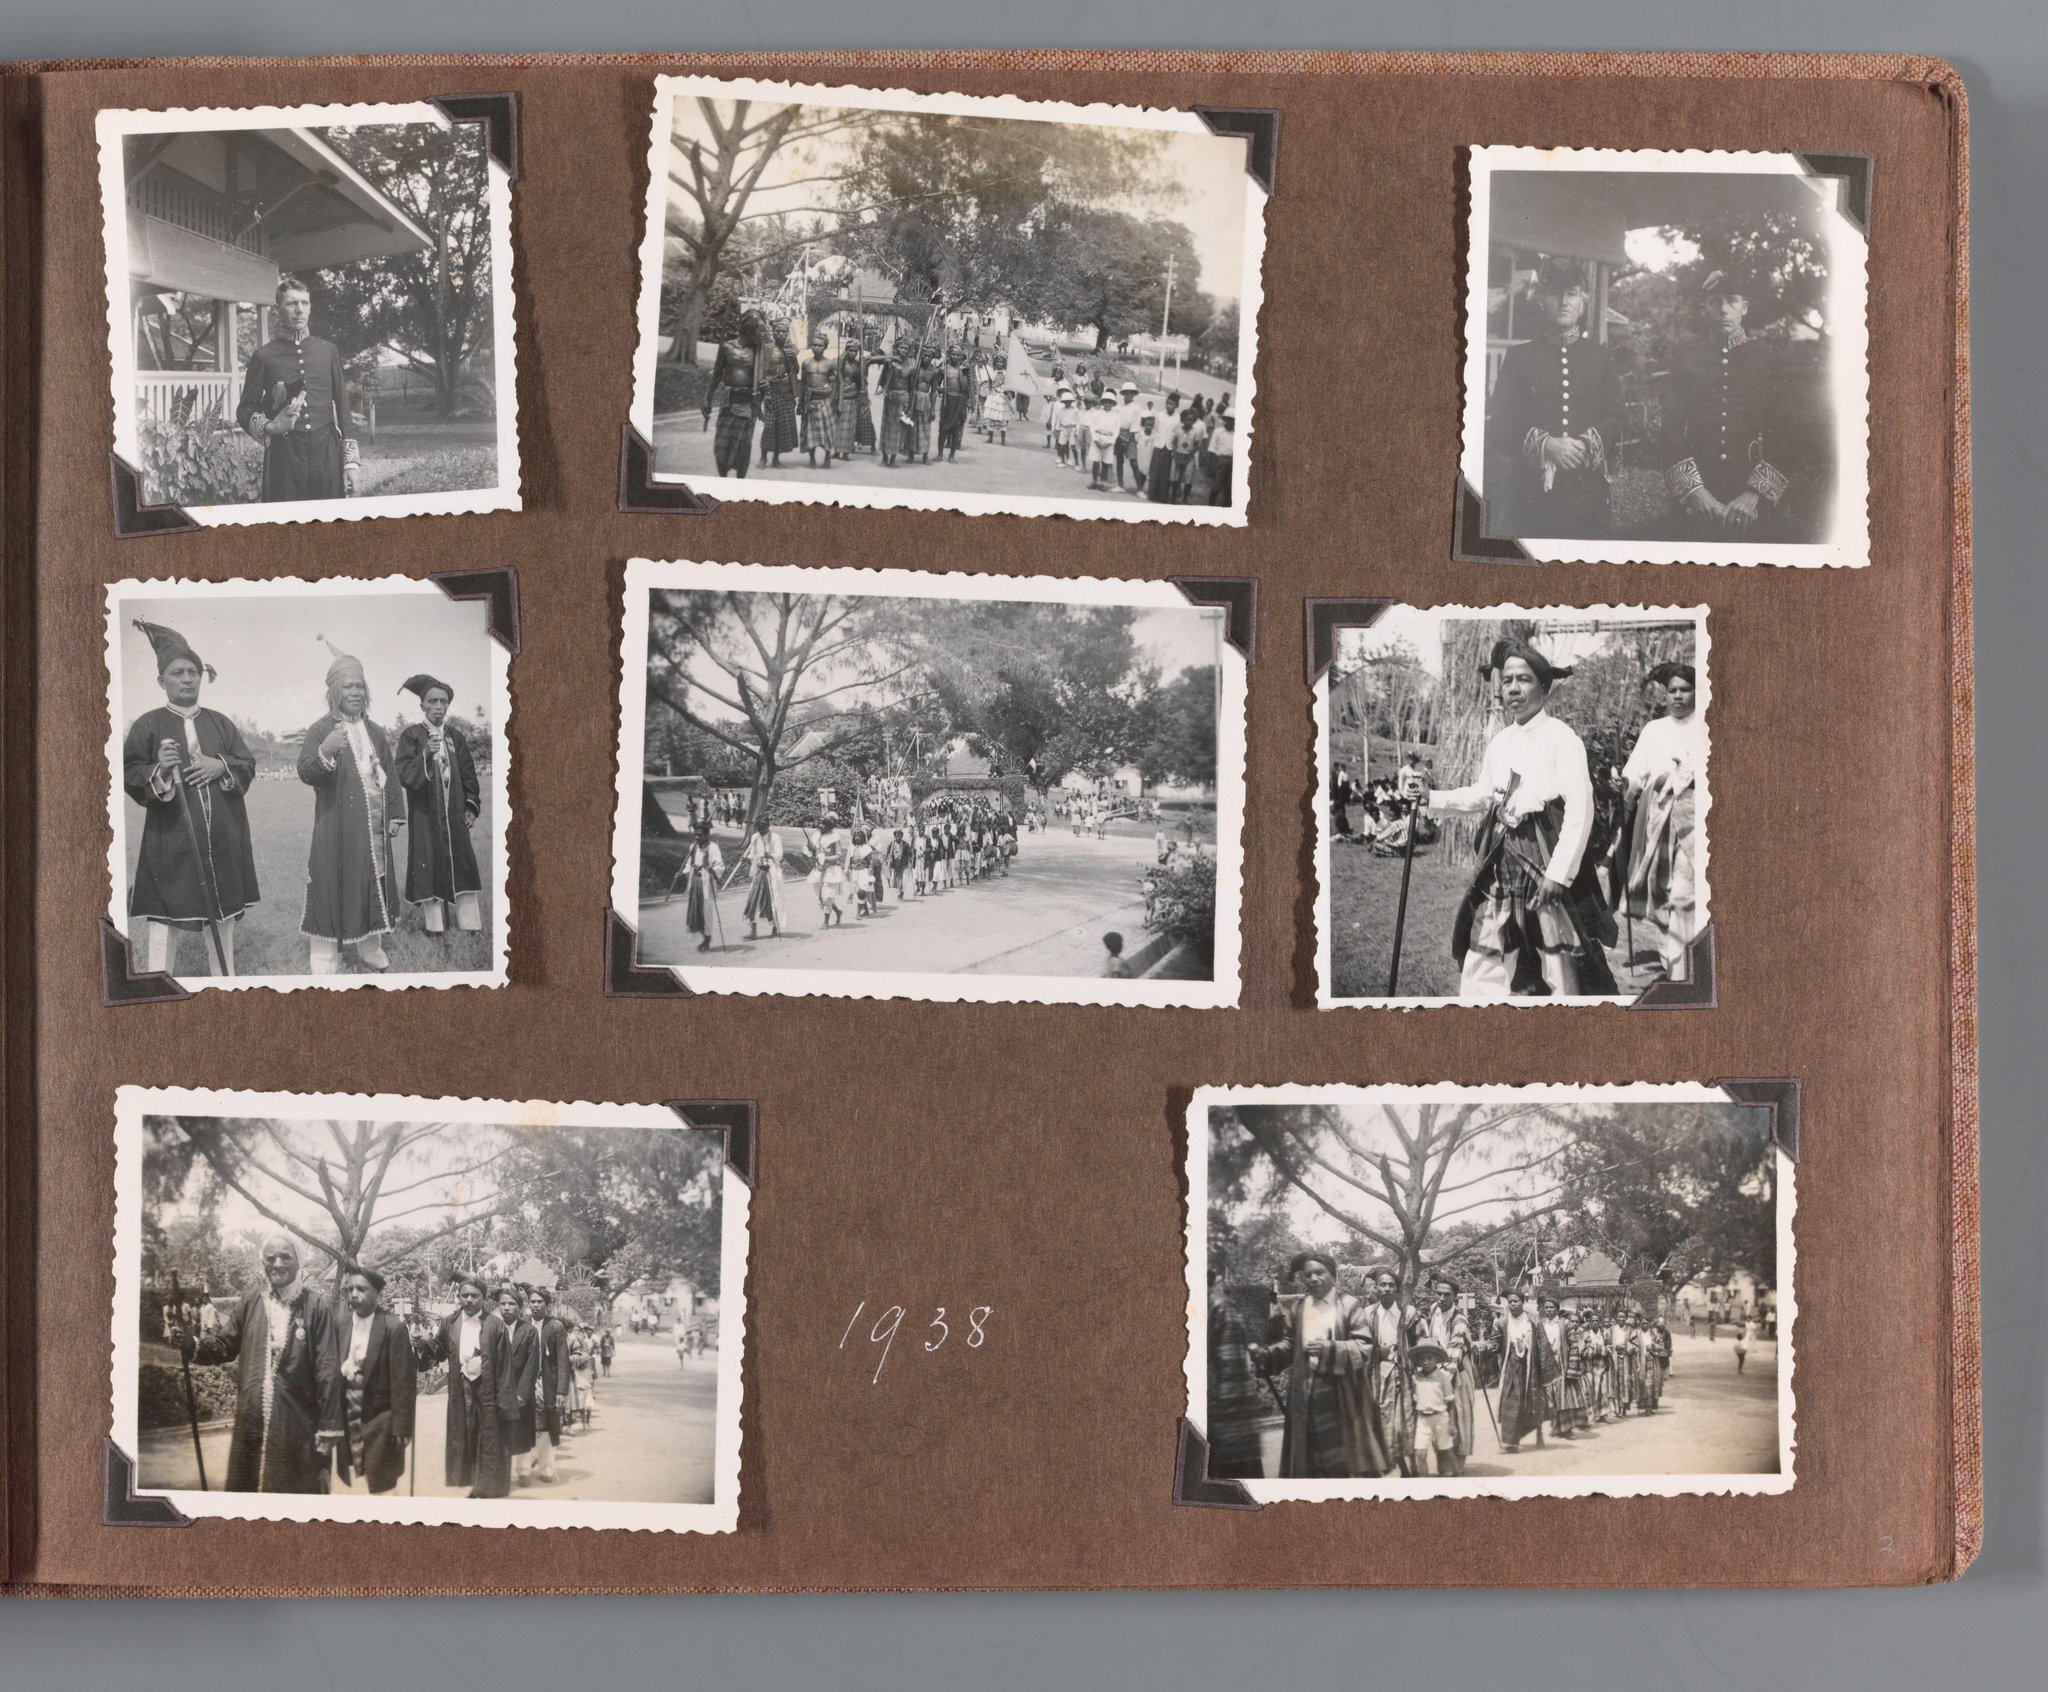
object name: photograph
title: Volksfeesten bij de geboorte van Prinses Beatrix 1938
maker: Anonymous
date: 1938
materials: cardboard, photographic support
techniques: gelatin silver print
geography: celebes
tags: beatrix (koningin der nederlanden), r.h. vonk, asiatic races and peoples (indonesians), public festivities at birth of royal persons, folk costume, regional costume, colonial government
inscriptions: inscription: ‘1938’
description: Albumblad met acht foto's van de volksfeesten te Baubau (Baoe-Baoe) op Zuid-Celebes ter gelegenheid van de geboorte van prinses Beatrix in 1938. Ook een optocht in adat kostuum. Met twee portretten van de assistent-residenten Vonk en Monad de Froideville, in groot tenue. Onderdeel van het fotoalbum van familie Vonk op Zuid-Celebes.